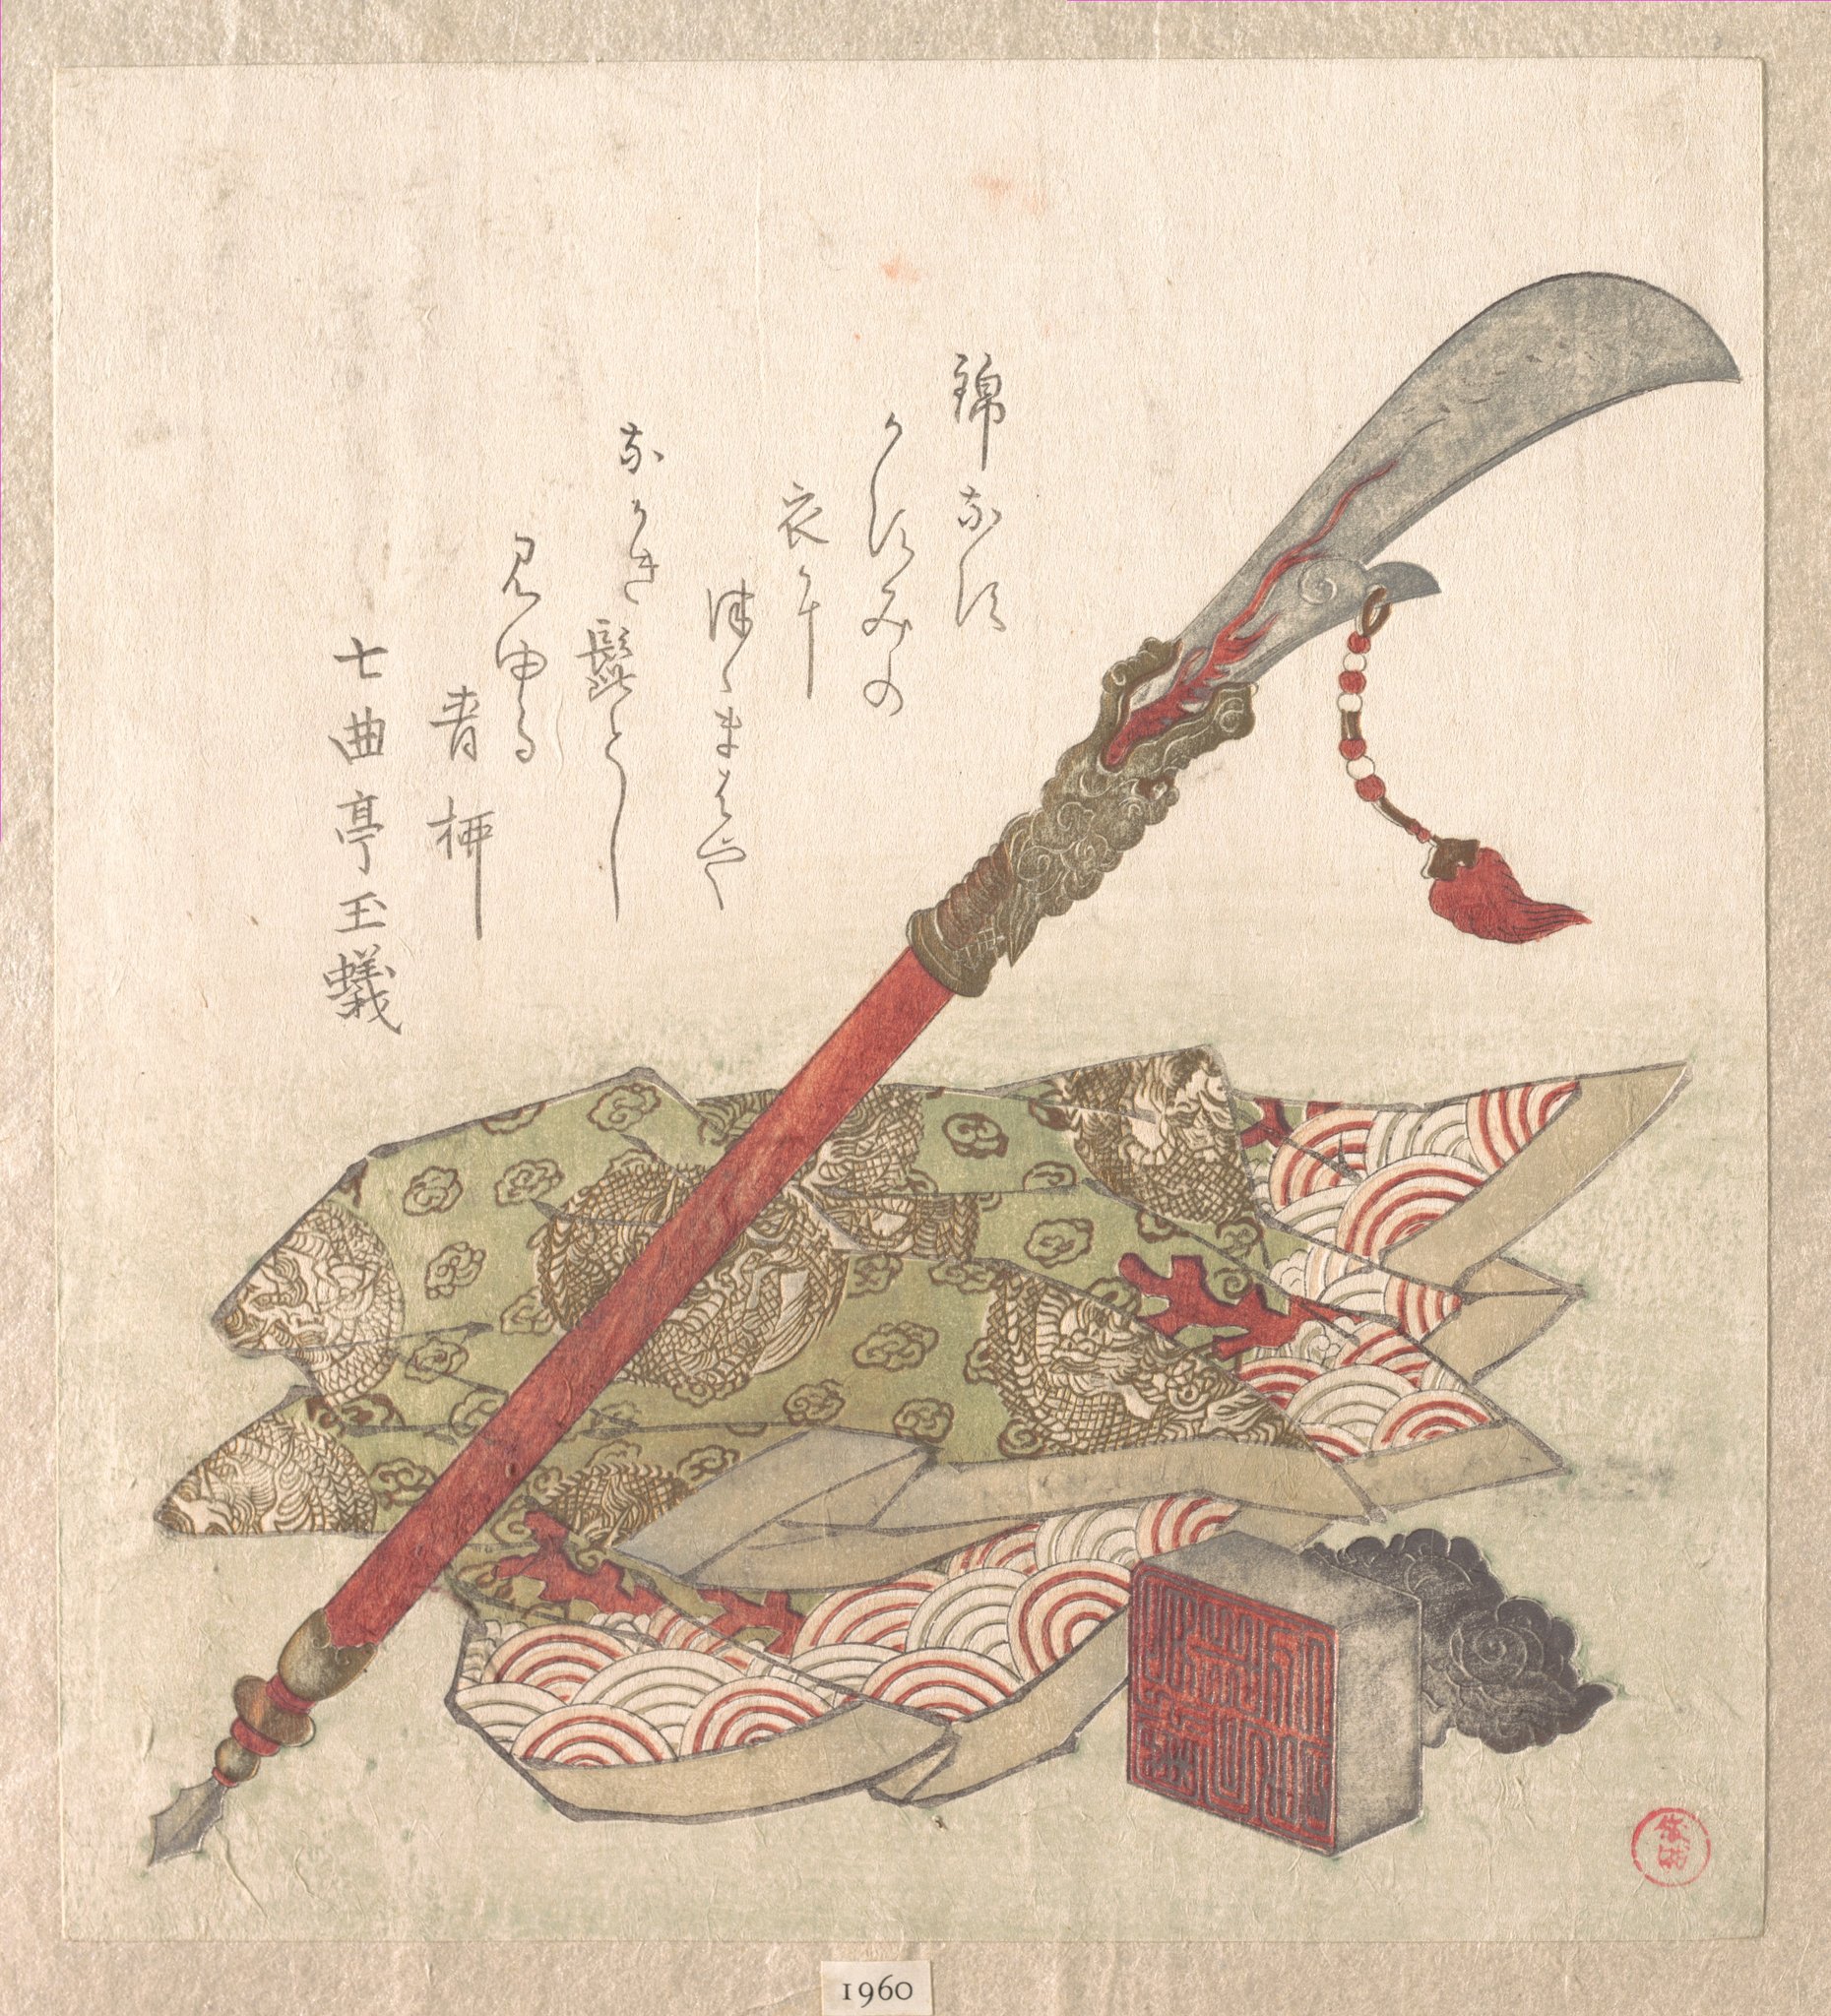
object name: woodblock print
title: Halberd, Brocade Robe and Seal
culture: japanese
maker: kubo shunman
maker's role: artist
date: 1801-1900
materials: ink, paper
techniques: surimono, woodblock print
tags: robes,weapons,seals